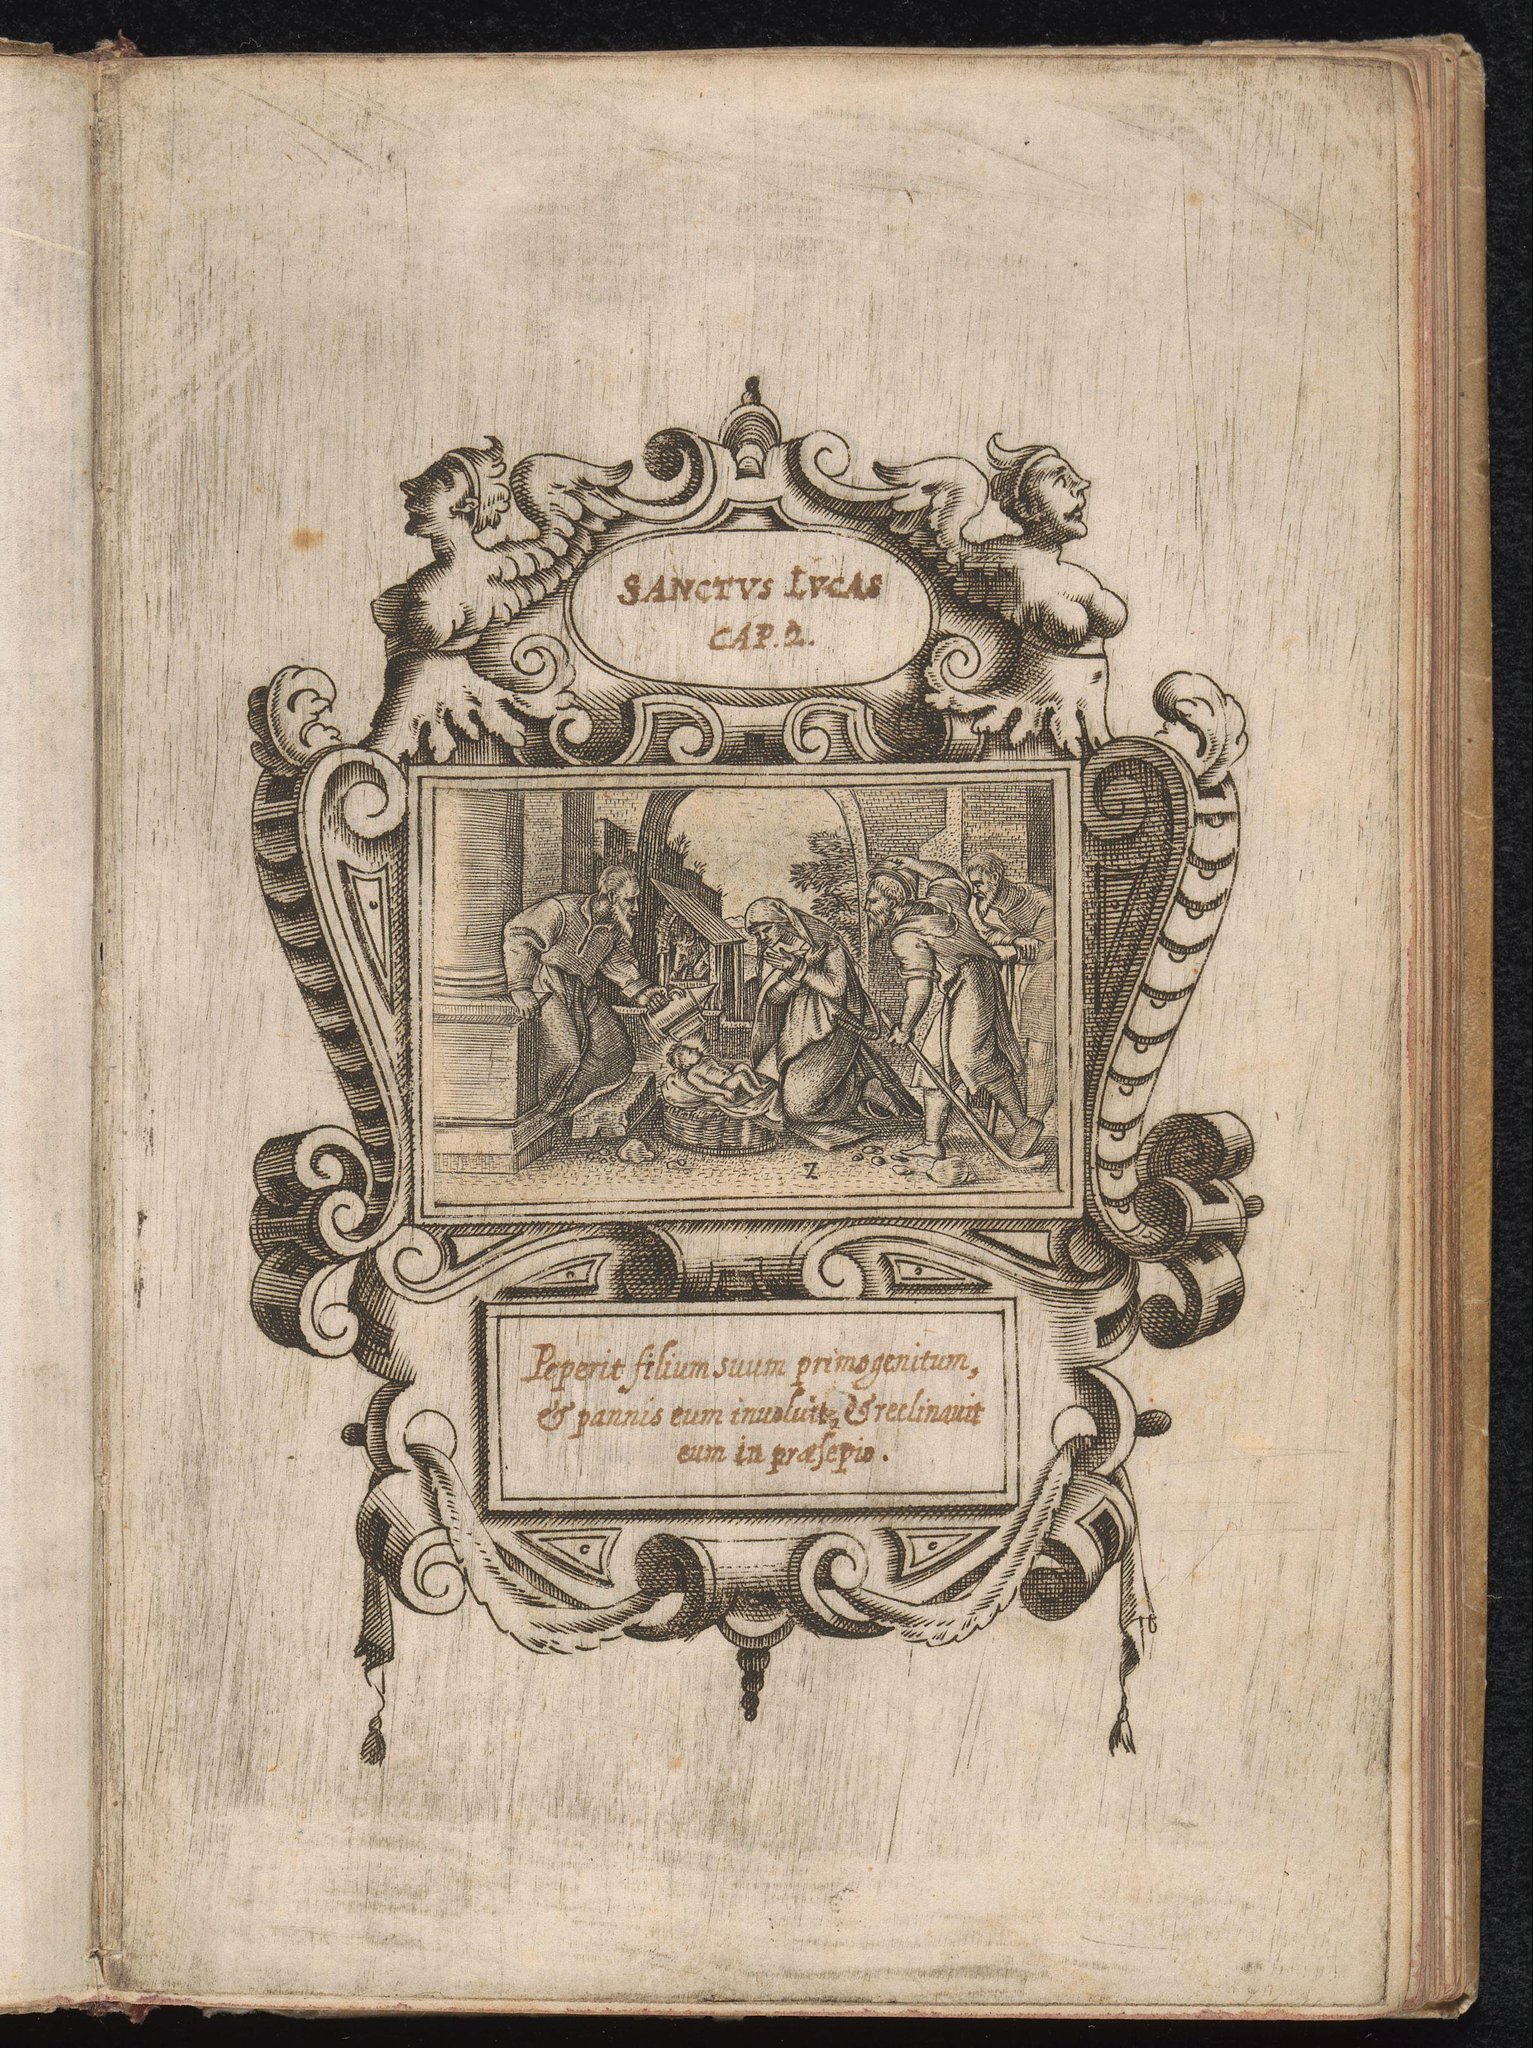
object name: print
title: Aanbidding door de herders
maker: monogrammist hsd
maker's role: print maker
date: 1570-1610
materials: paper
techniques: engraving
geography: antwerp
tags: adoration of the christ-child by the shepherds; mary and joseph present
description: Aanbidding door de herders. Onderdeel van een prentalbum met titelprent en 56 scènes uit het Nieuwe Testament. Elke voorstelling gemonteerd in een gravure met ornamentele cartouches waarin een venster is gesneden en voorzien van handgeschreven bijbelpassages.